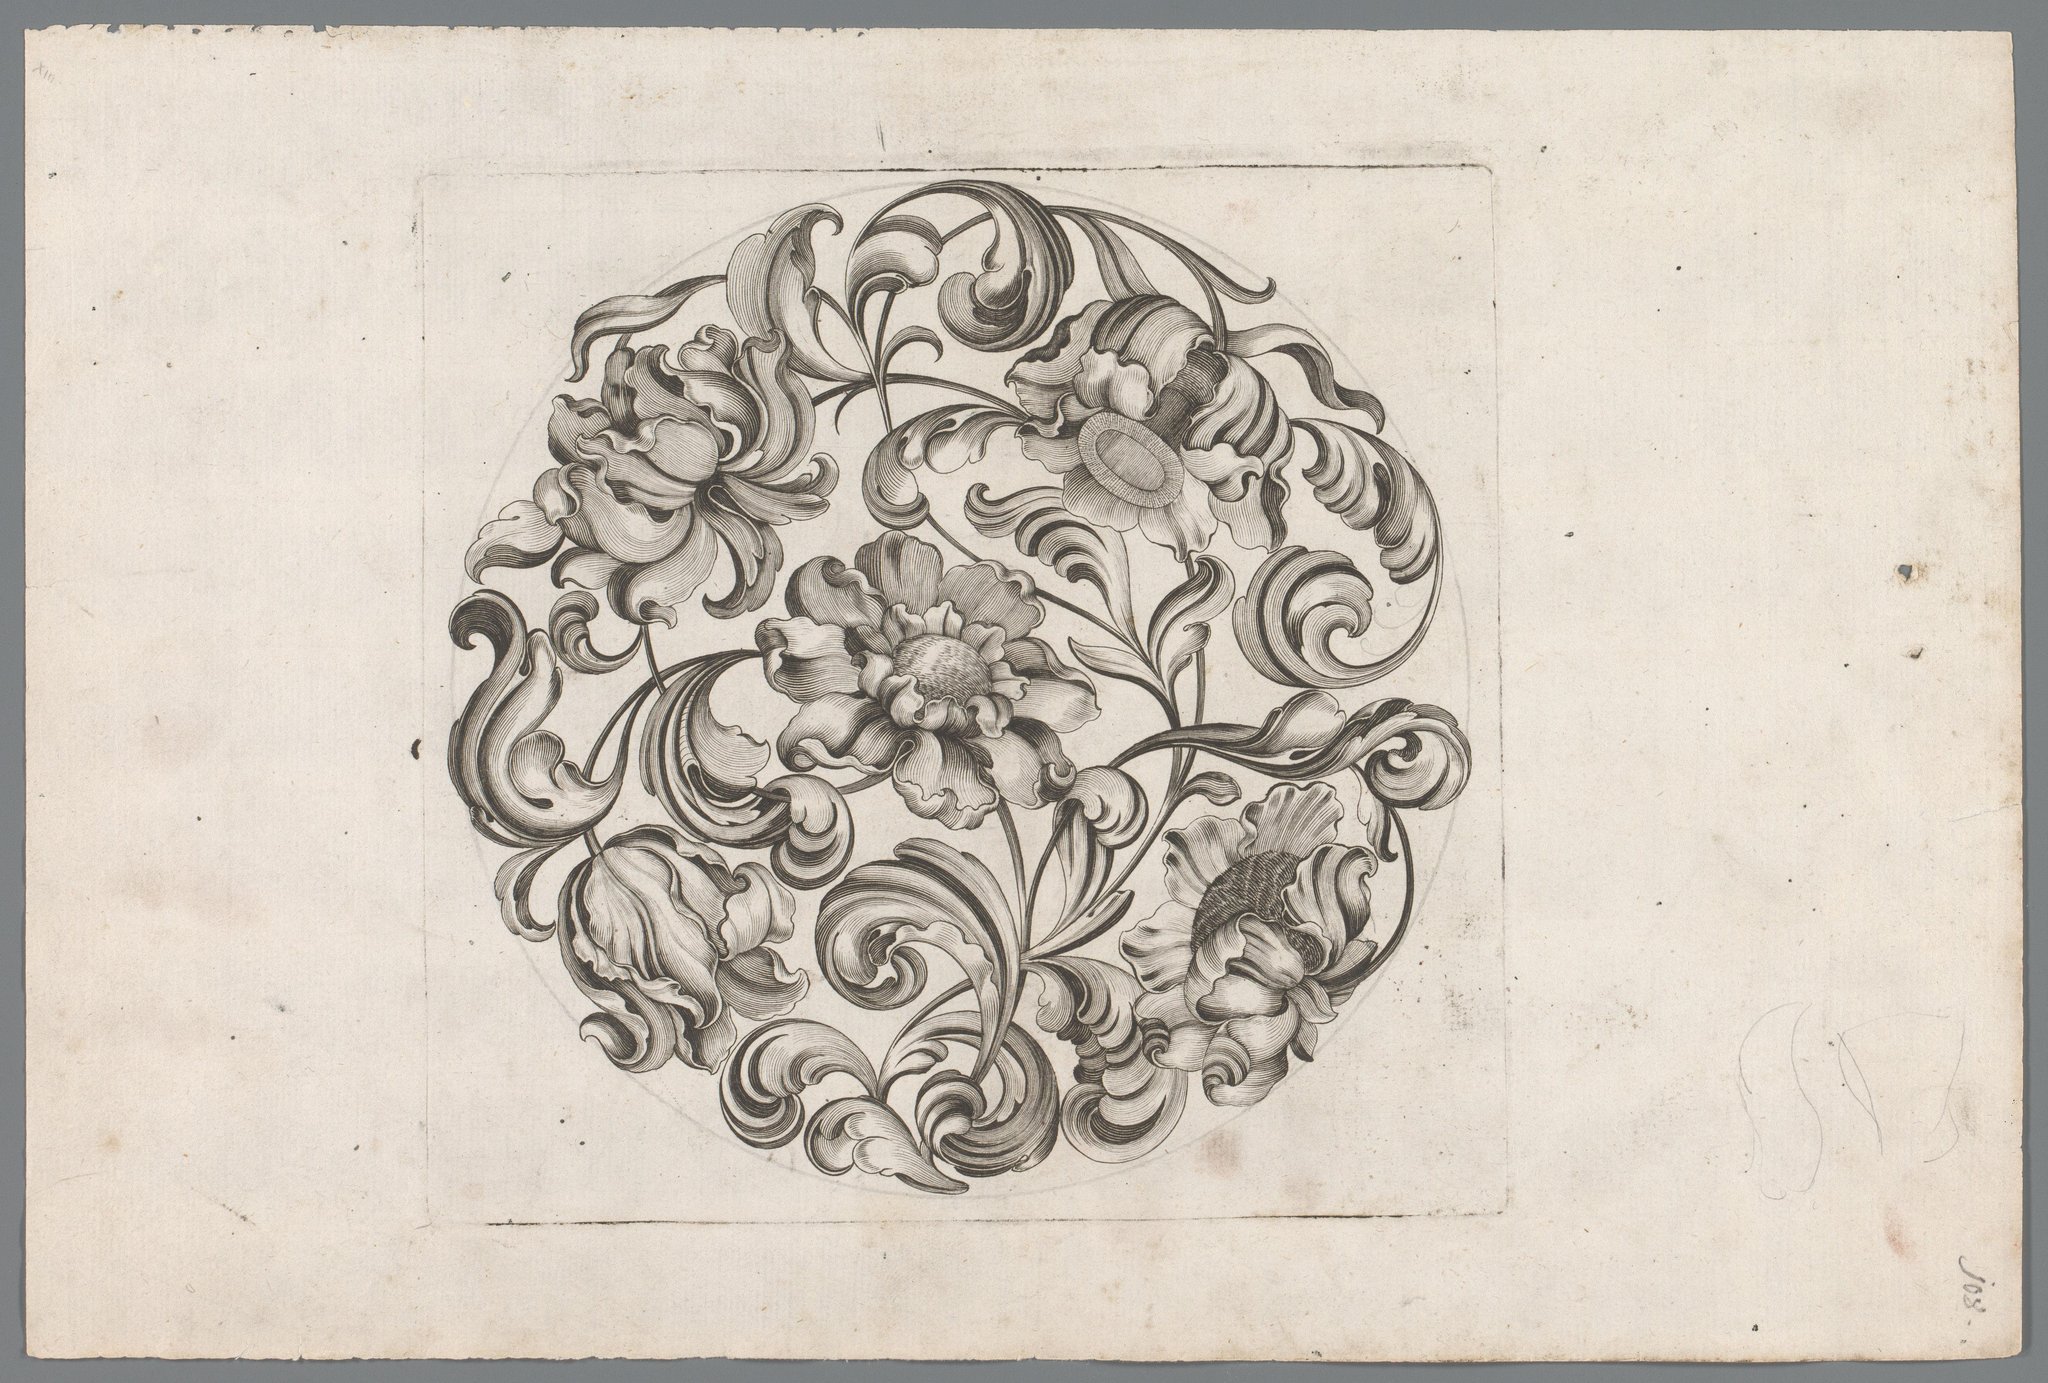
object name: ornament print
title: Krans met vijf bloemen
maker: johann ulrich stapf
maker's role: print maker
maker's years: 1642-1706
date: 1660-1665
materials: paper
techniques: engraving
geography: augsburg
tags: garland, wreath, flowers ~ ornament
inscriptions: collector's mark: Lugt 2228, collector's mark: Lugt 2760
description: Prent maakt deel uit van een serie van vier prenten.